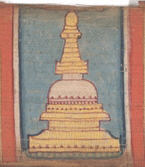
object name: folio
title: Folio from a Manuscript of the Ashtasahasrika Prajnaparamita (Perfection of Wisdom)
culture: indian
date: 1101-1200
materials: ink, leaf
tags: buddhism,stupas